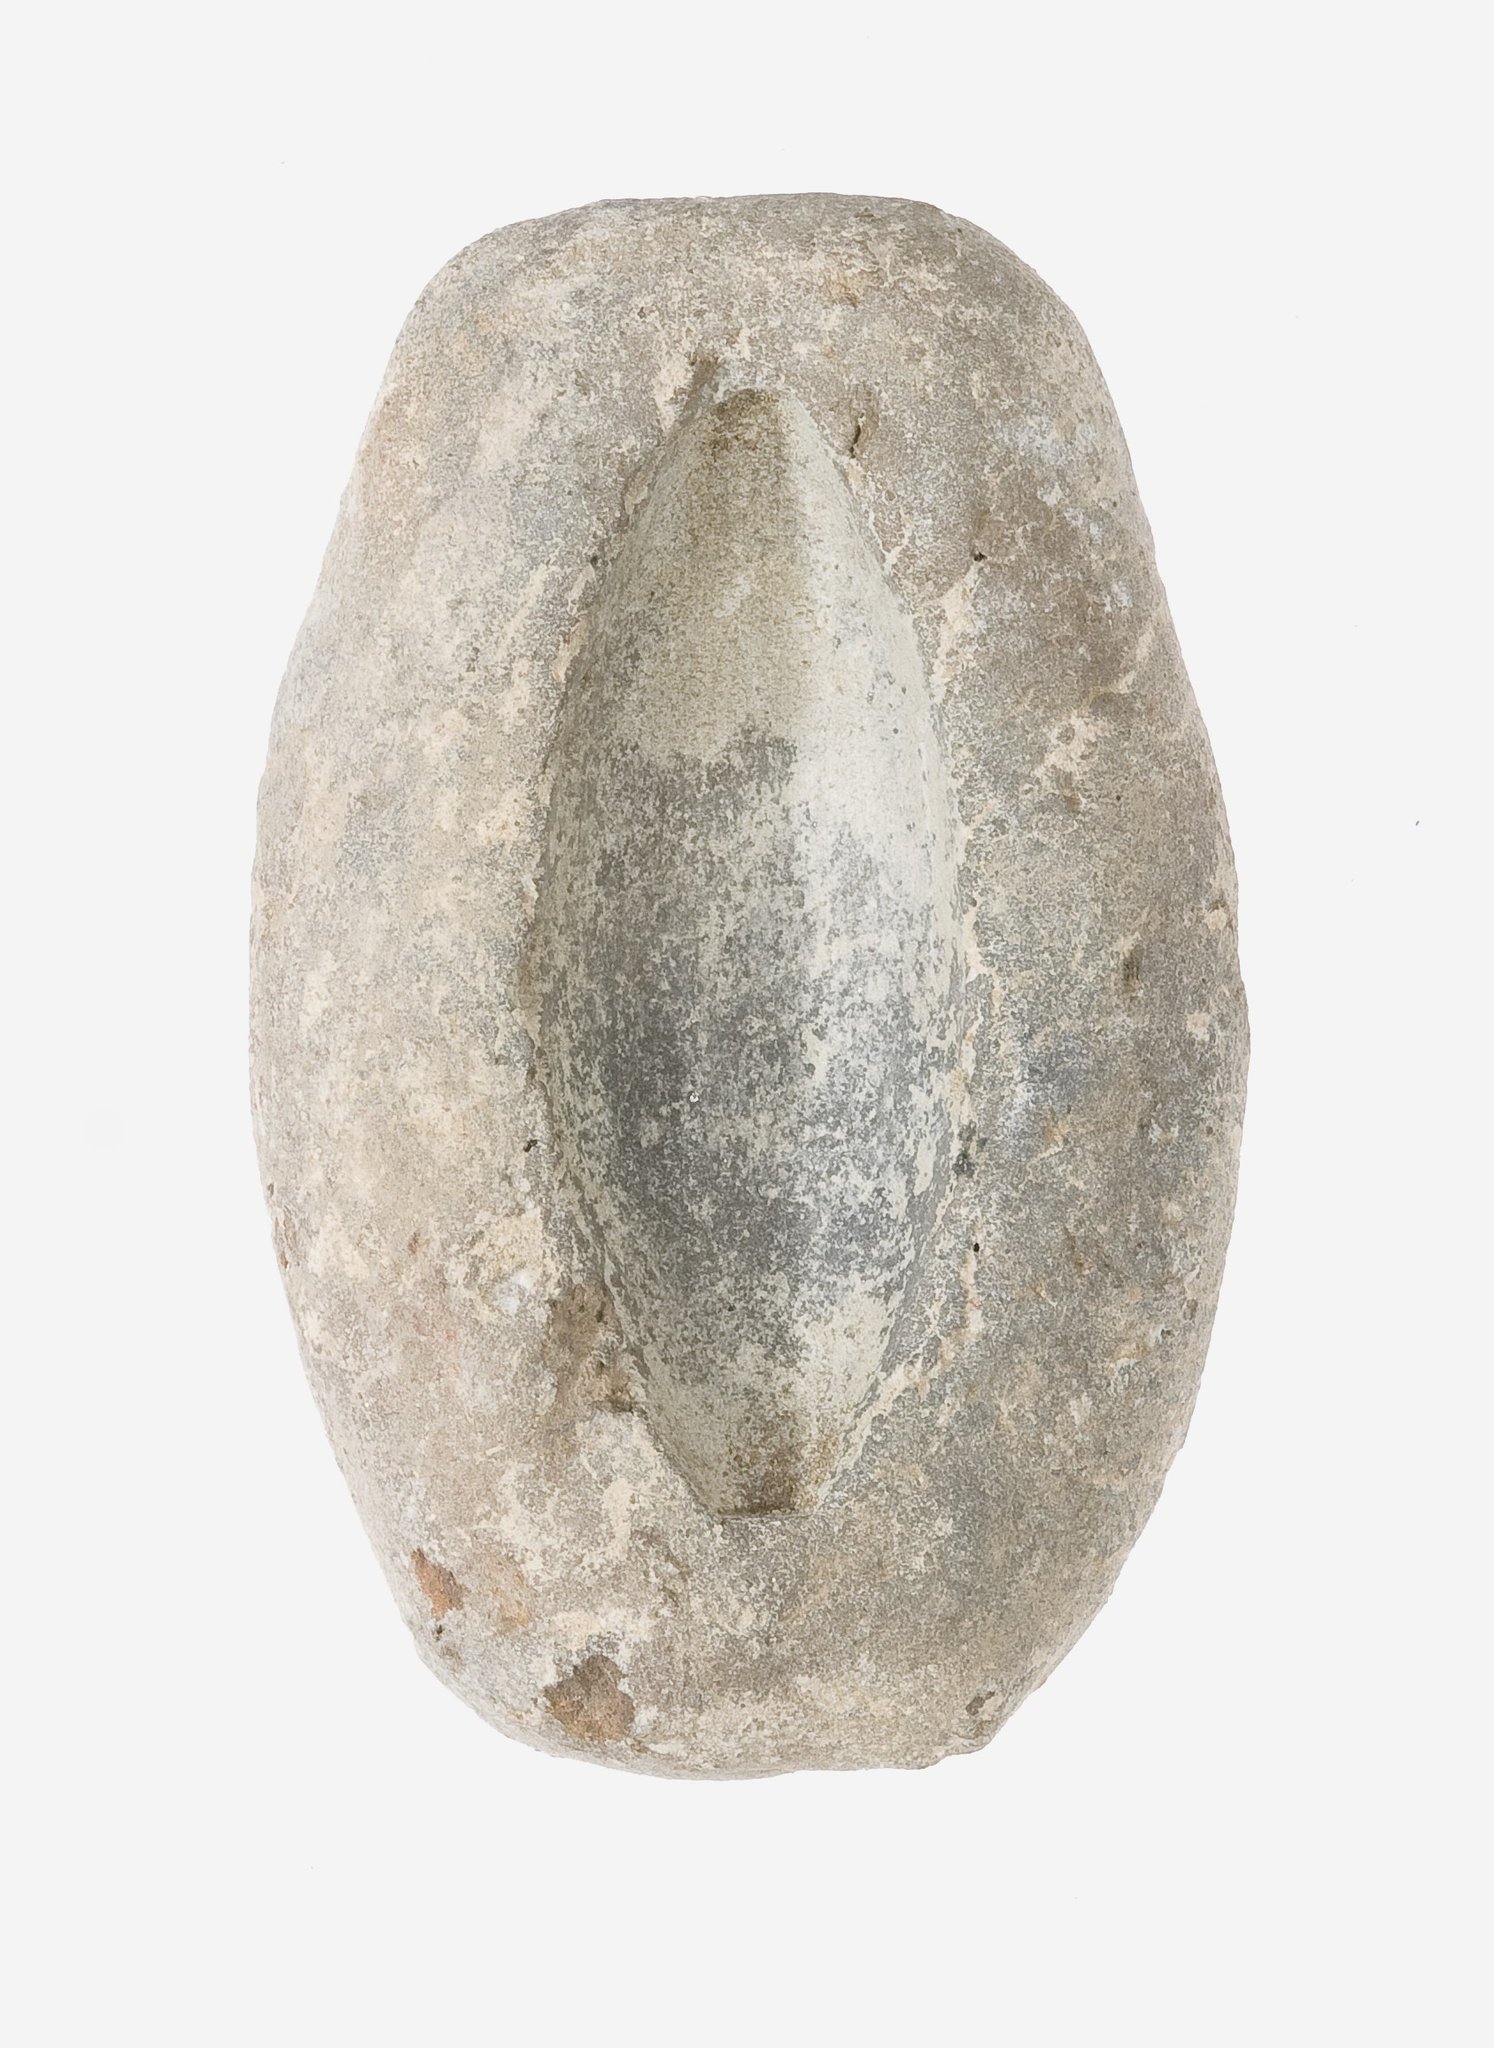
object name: mold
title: Mold for Ovoid Ornaments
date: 1390-1352 BCE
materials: pottery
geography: egypt